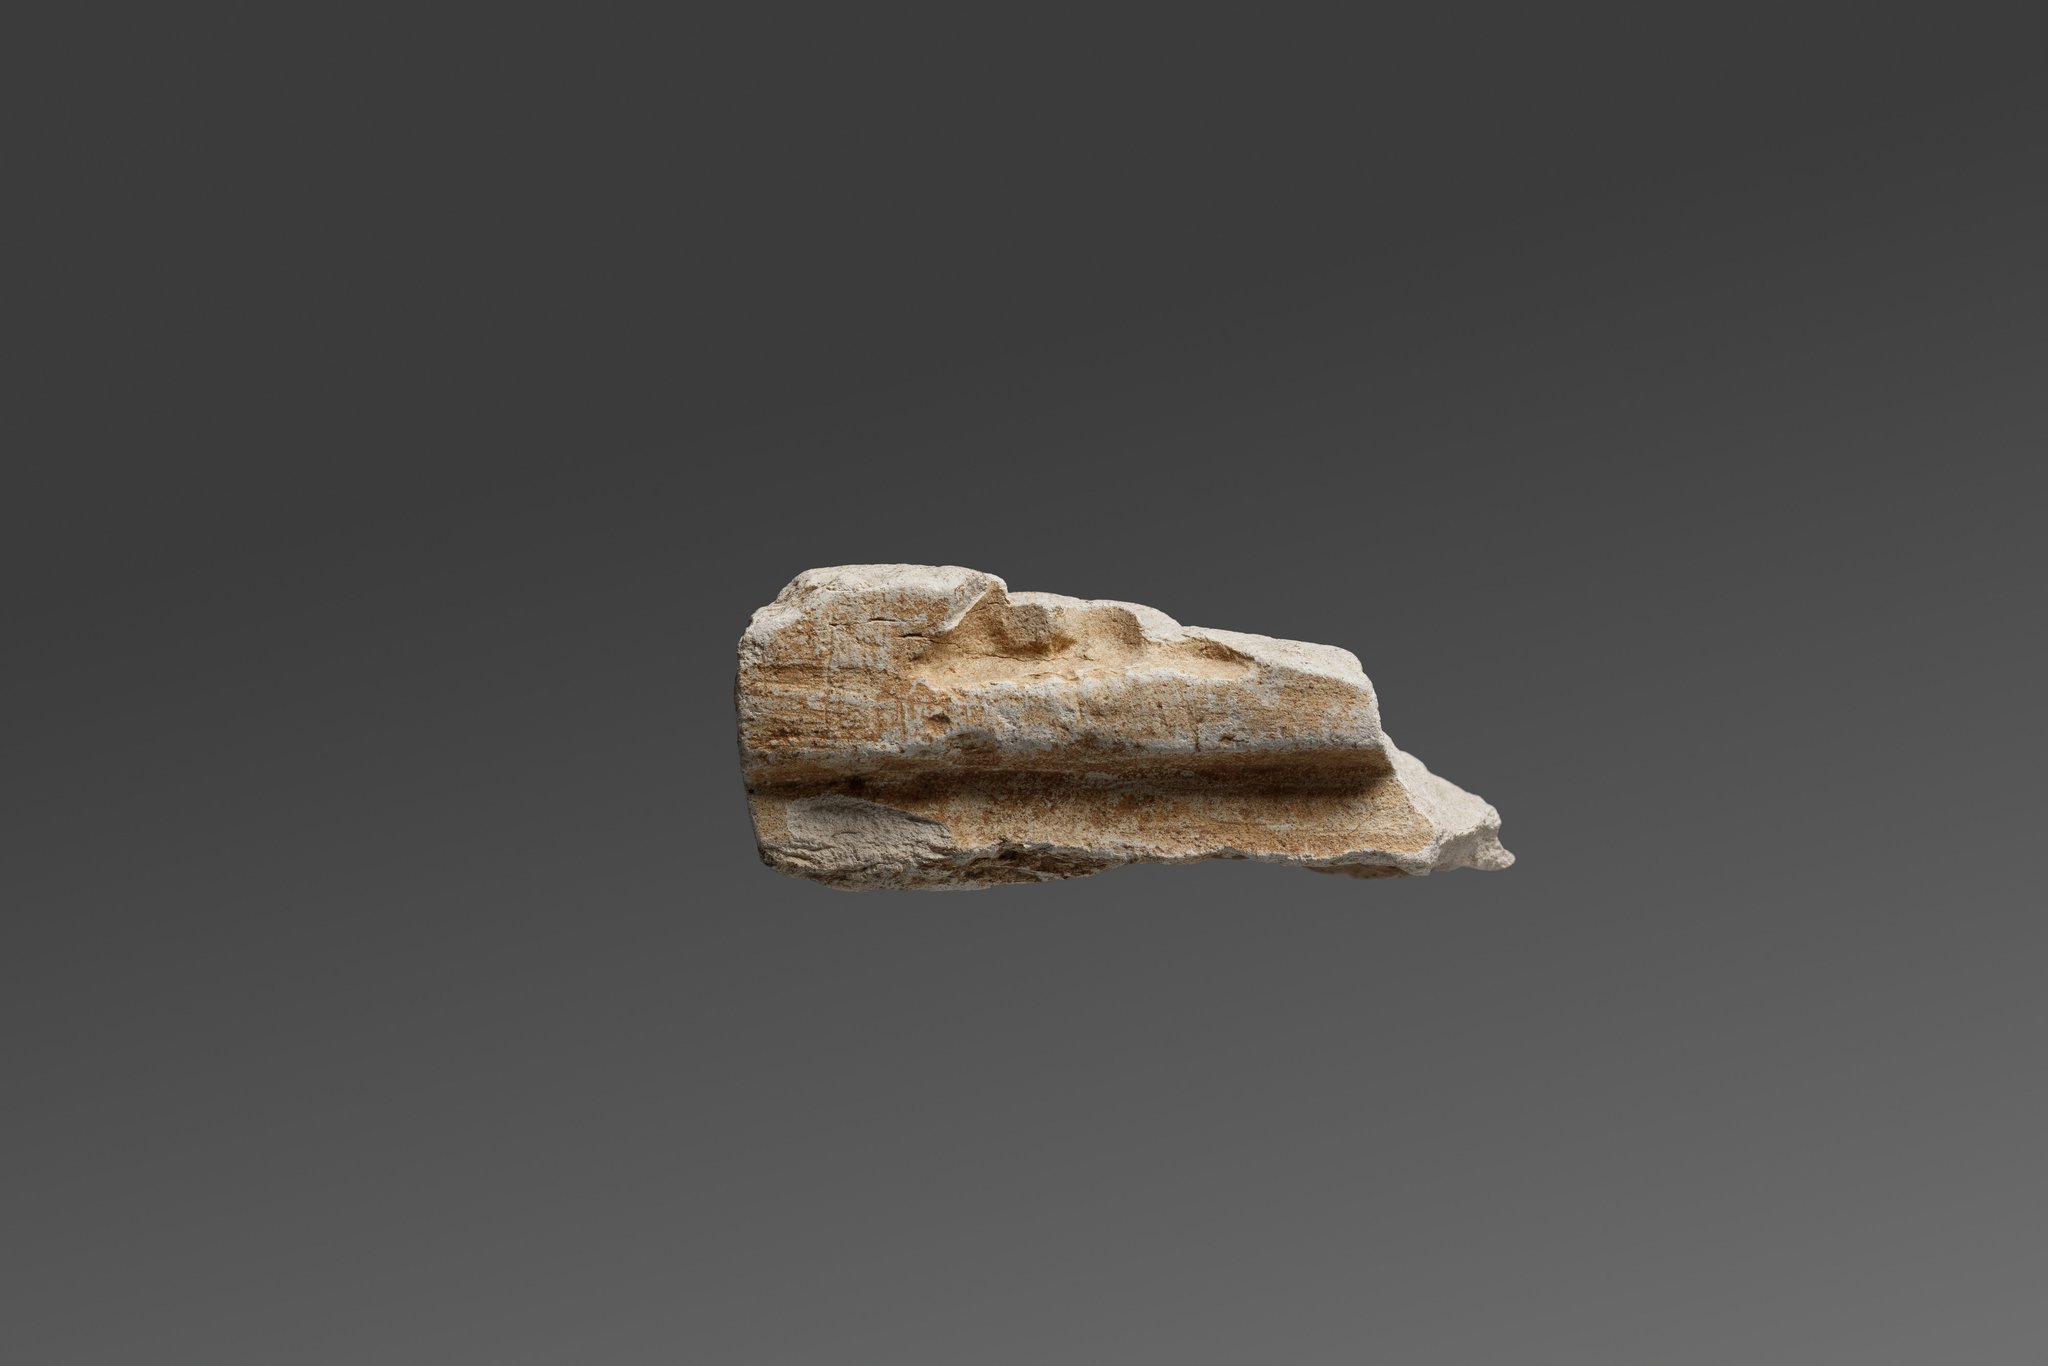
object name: relief fragment 47, tomb of mereri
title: Relief fragment possibly from the tomb of Mereri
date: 2100-2090 BCE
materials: stone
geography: egypt